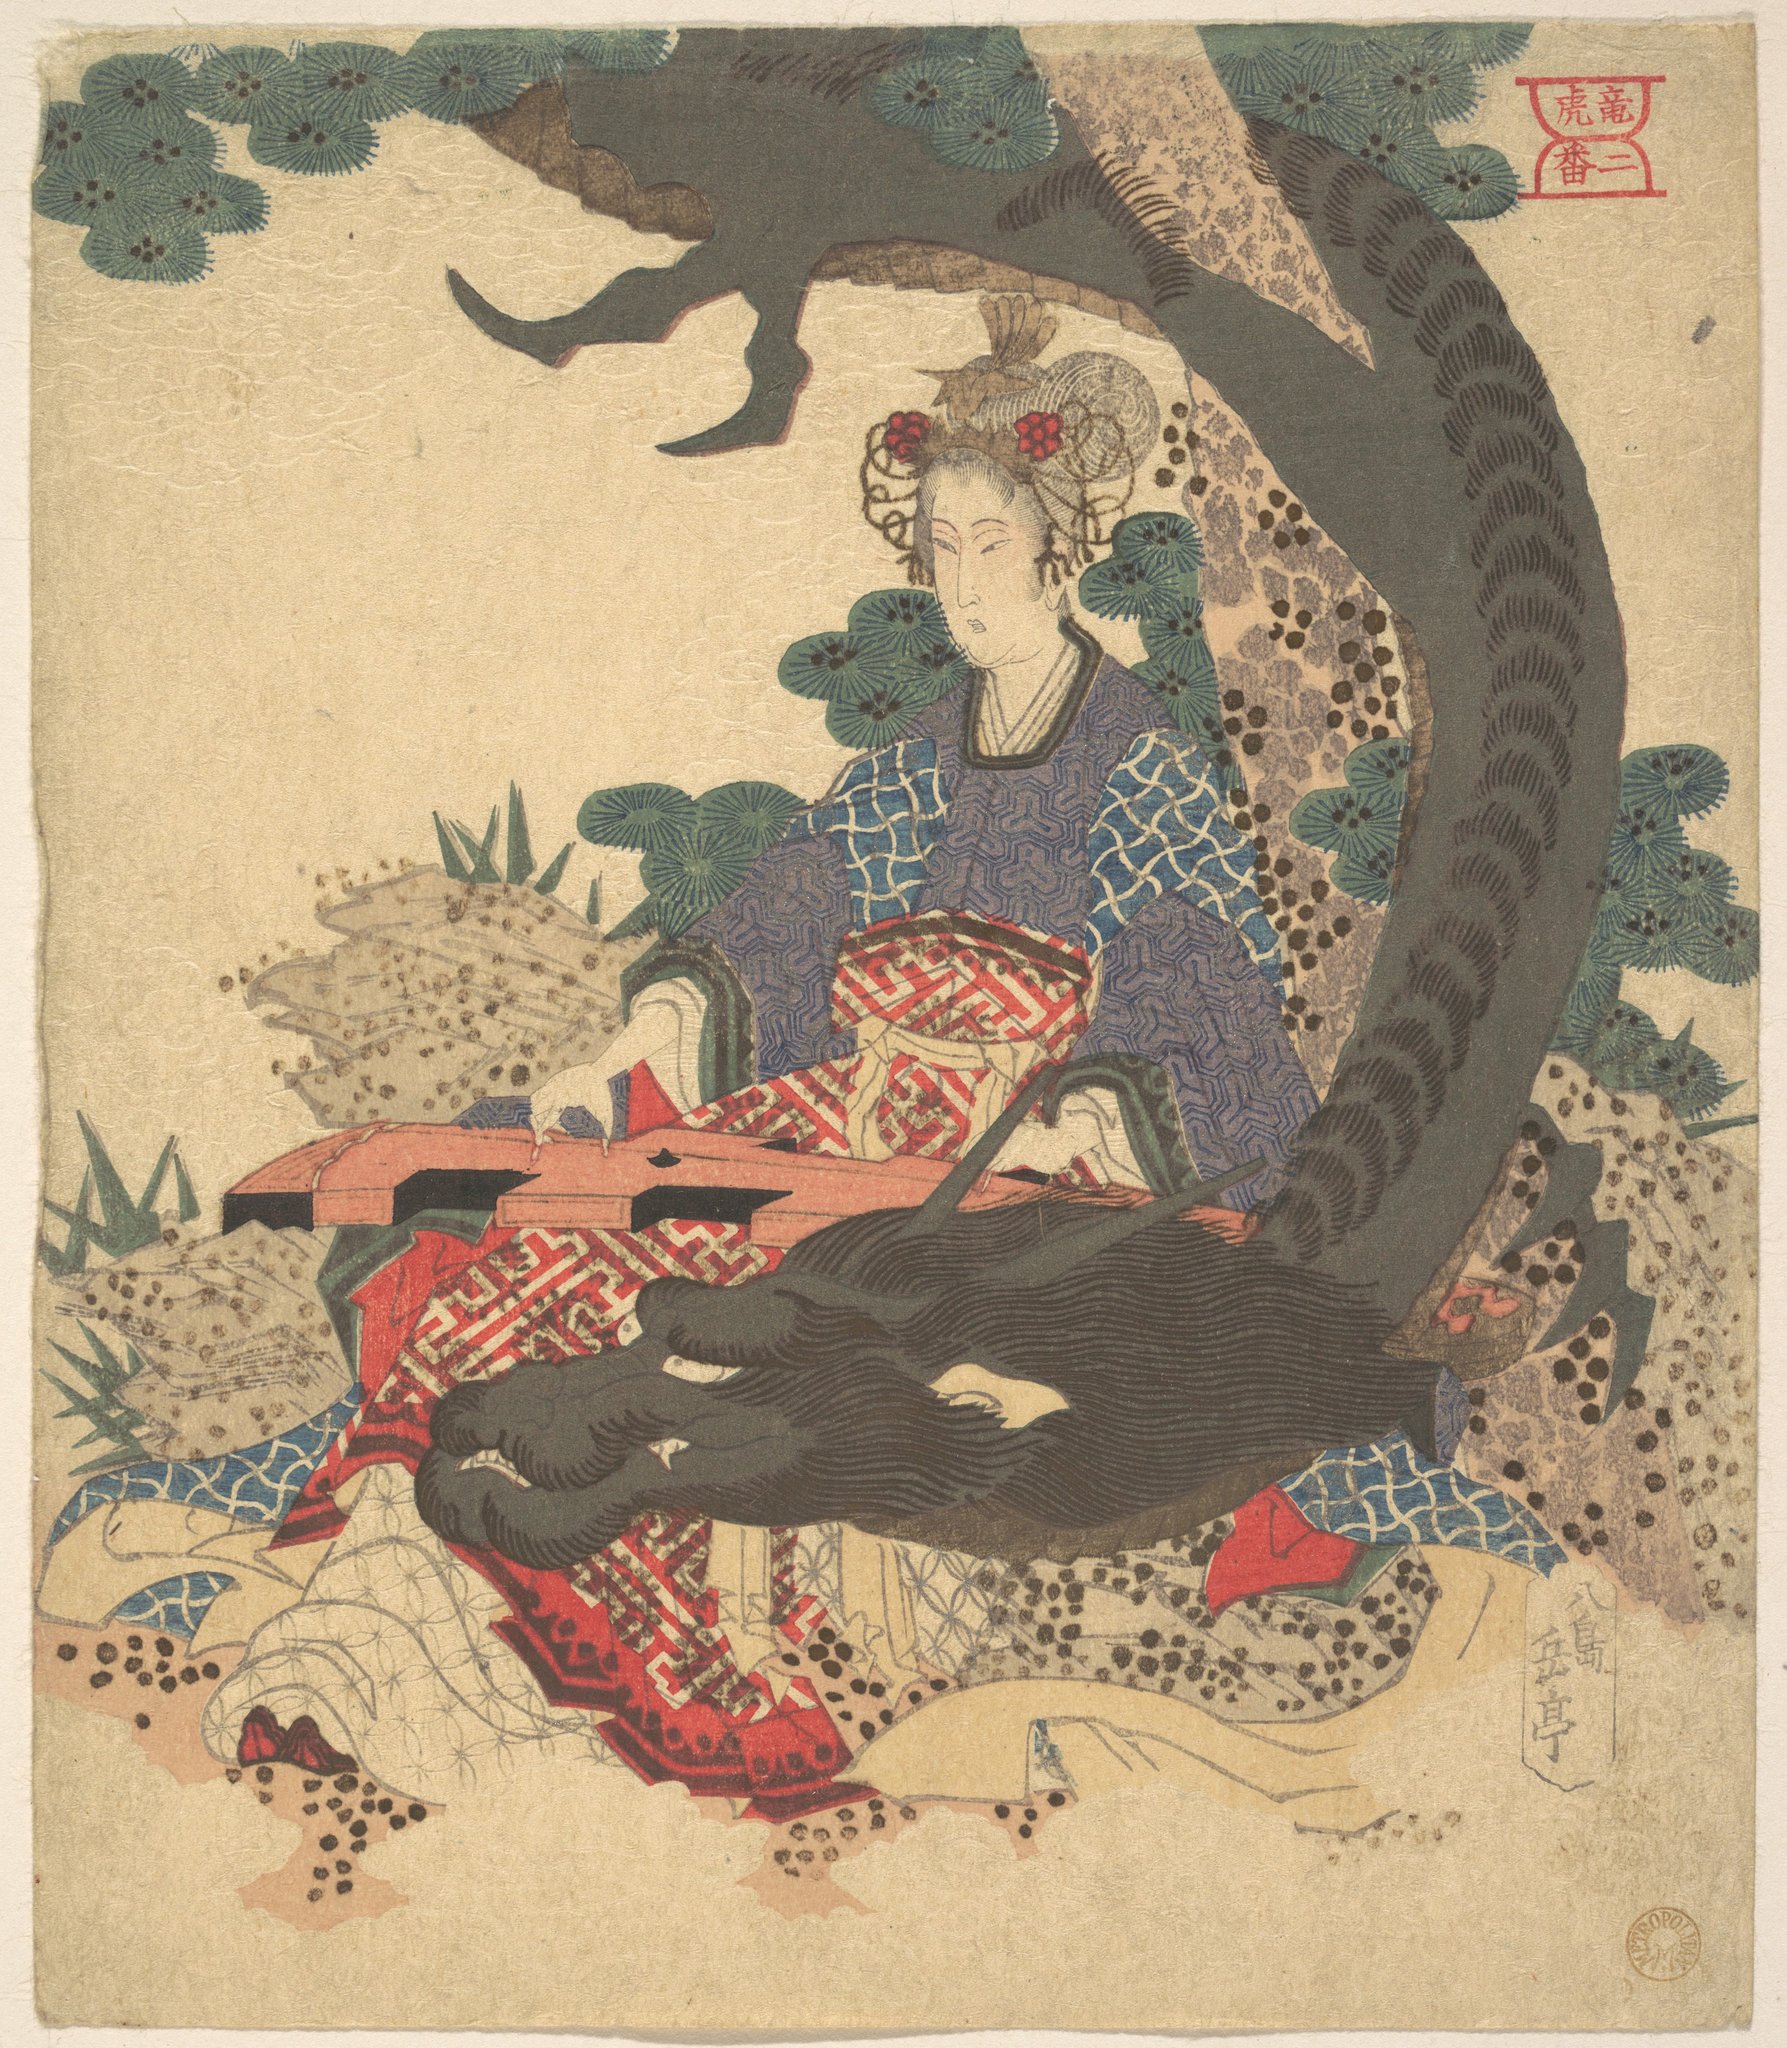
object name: print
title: Benzaiten ni Ryu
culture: japanese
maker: yashima gakutei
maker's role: artist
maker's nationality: japanese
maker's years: 1786-1868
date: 1786-1868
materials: ink, paper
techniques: surimono, woodblock print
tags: musical instruments,women,dragons